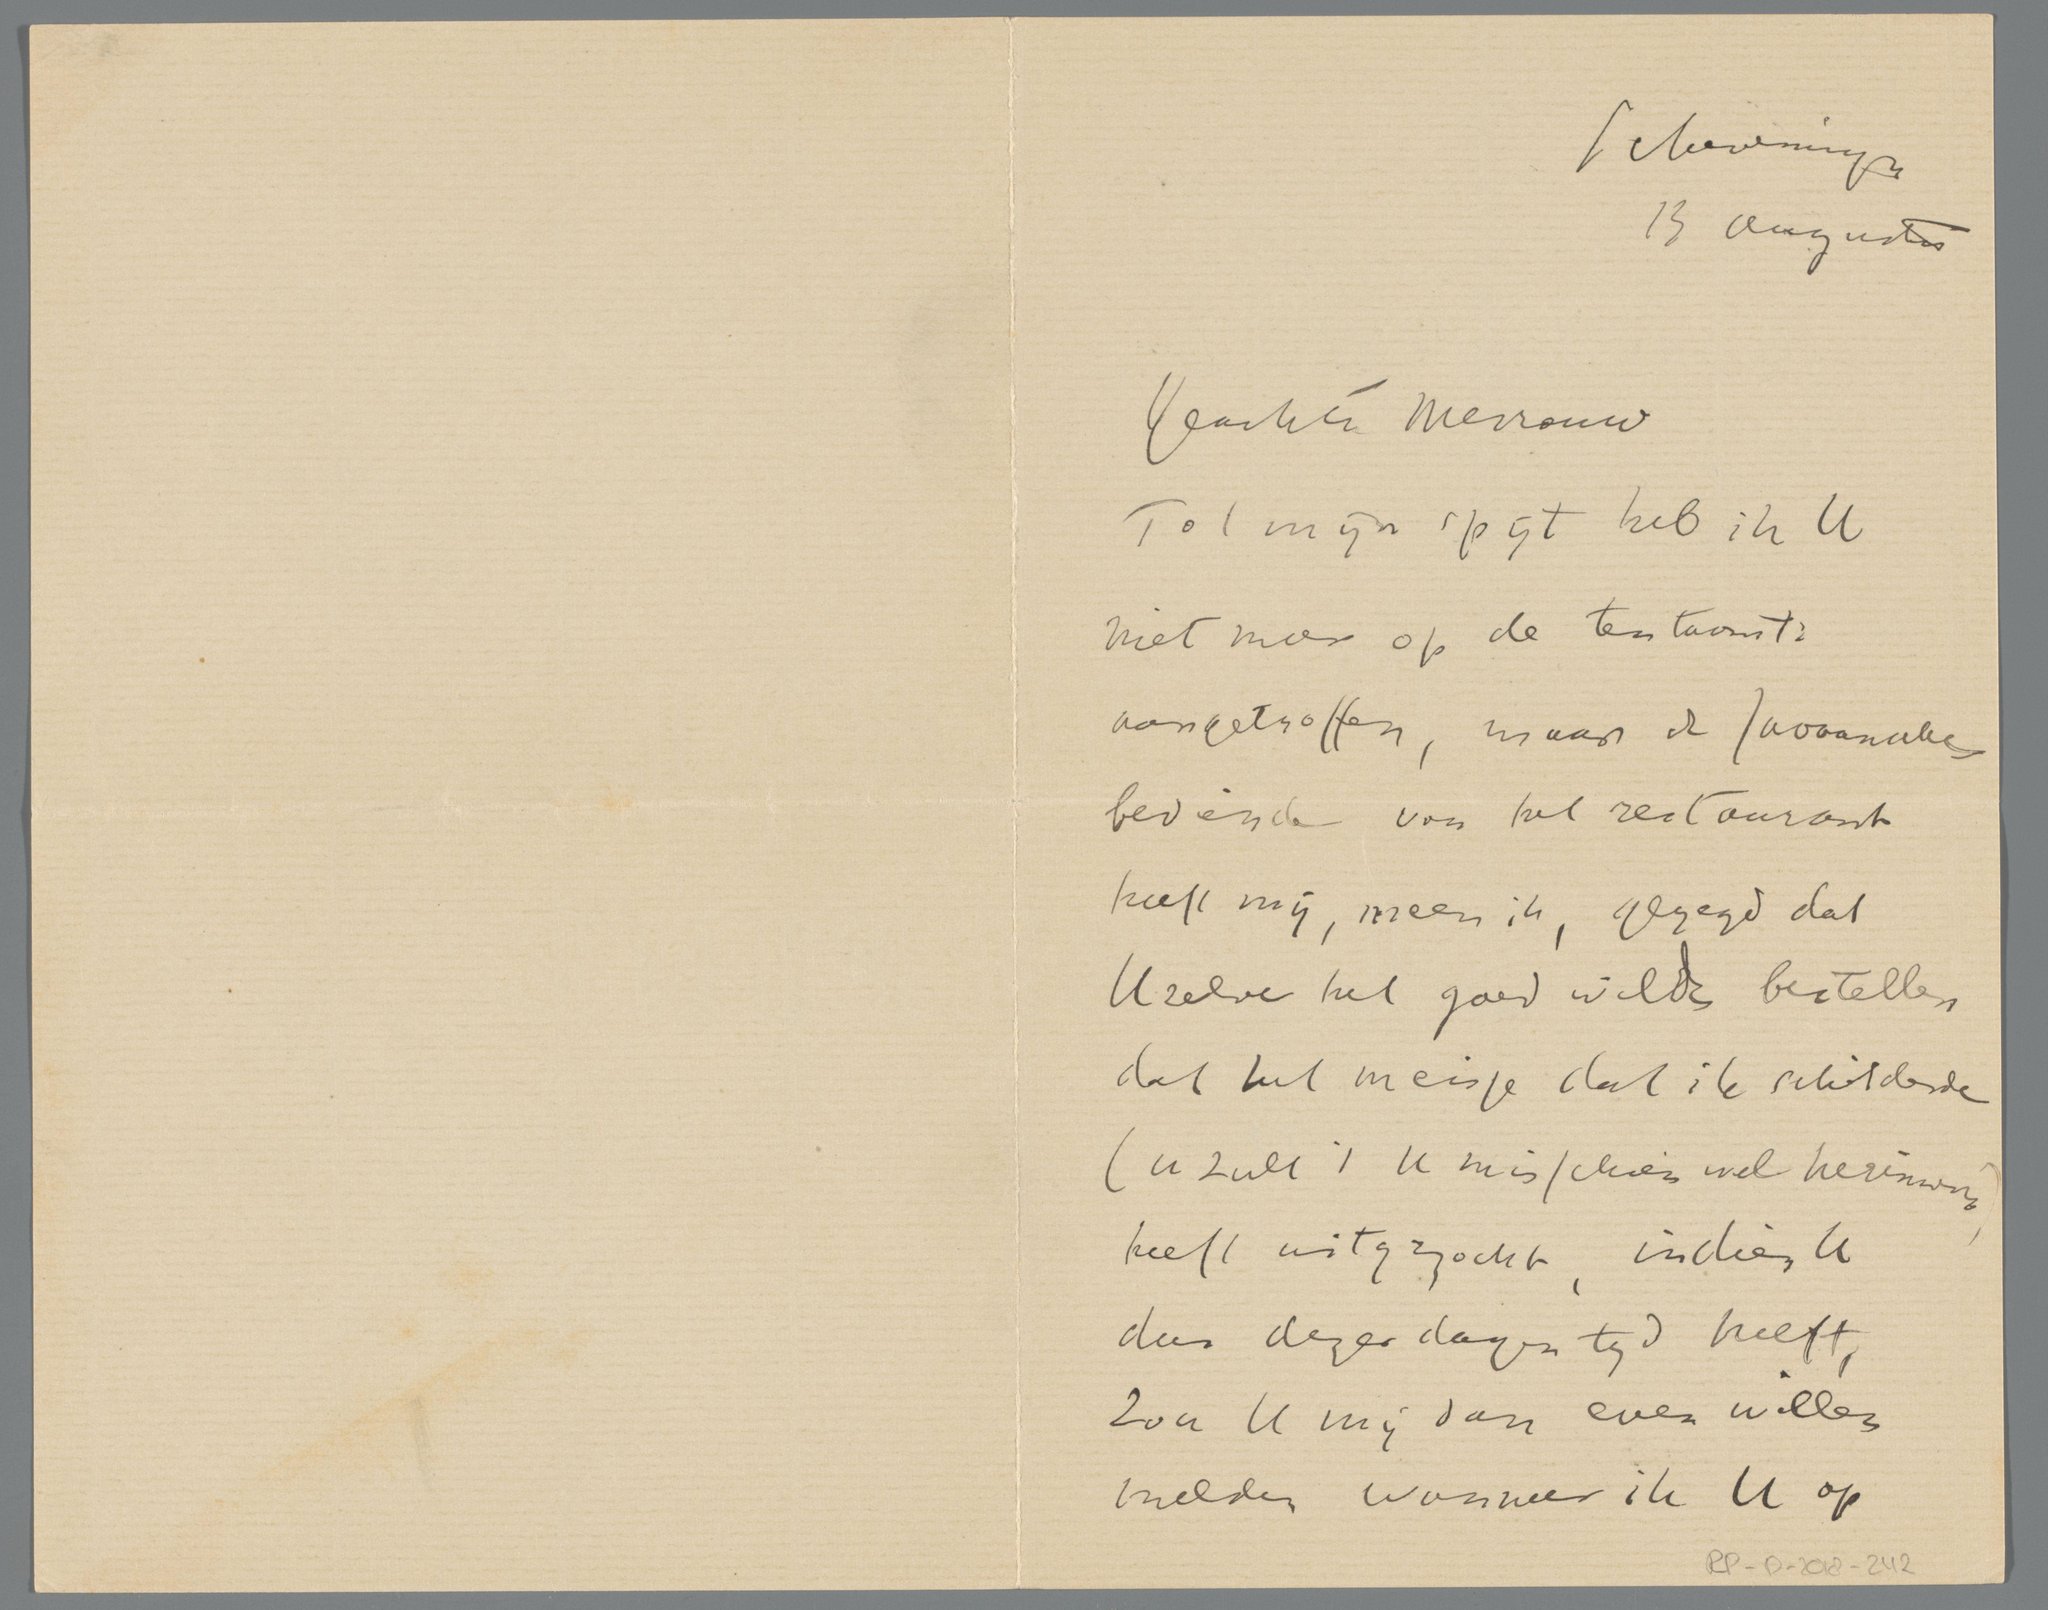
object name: letter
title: Brief aan Jeannette Bouman-Stuyling de Lange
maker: isaac israels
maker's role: draughtsman, painter, print maker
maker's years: 1865-1934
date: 1898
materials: ink, paper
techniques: pen, writing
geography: scheveningen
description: Brief gericht aan Mevrouw Bouman de Lange, Bezuidenhout, Den Haag.